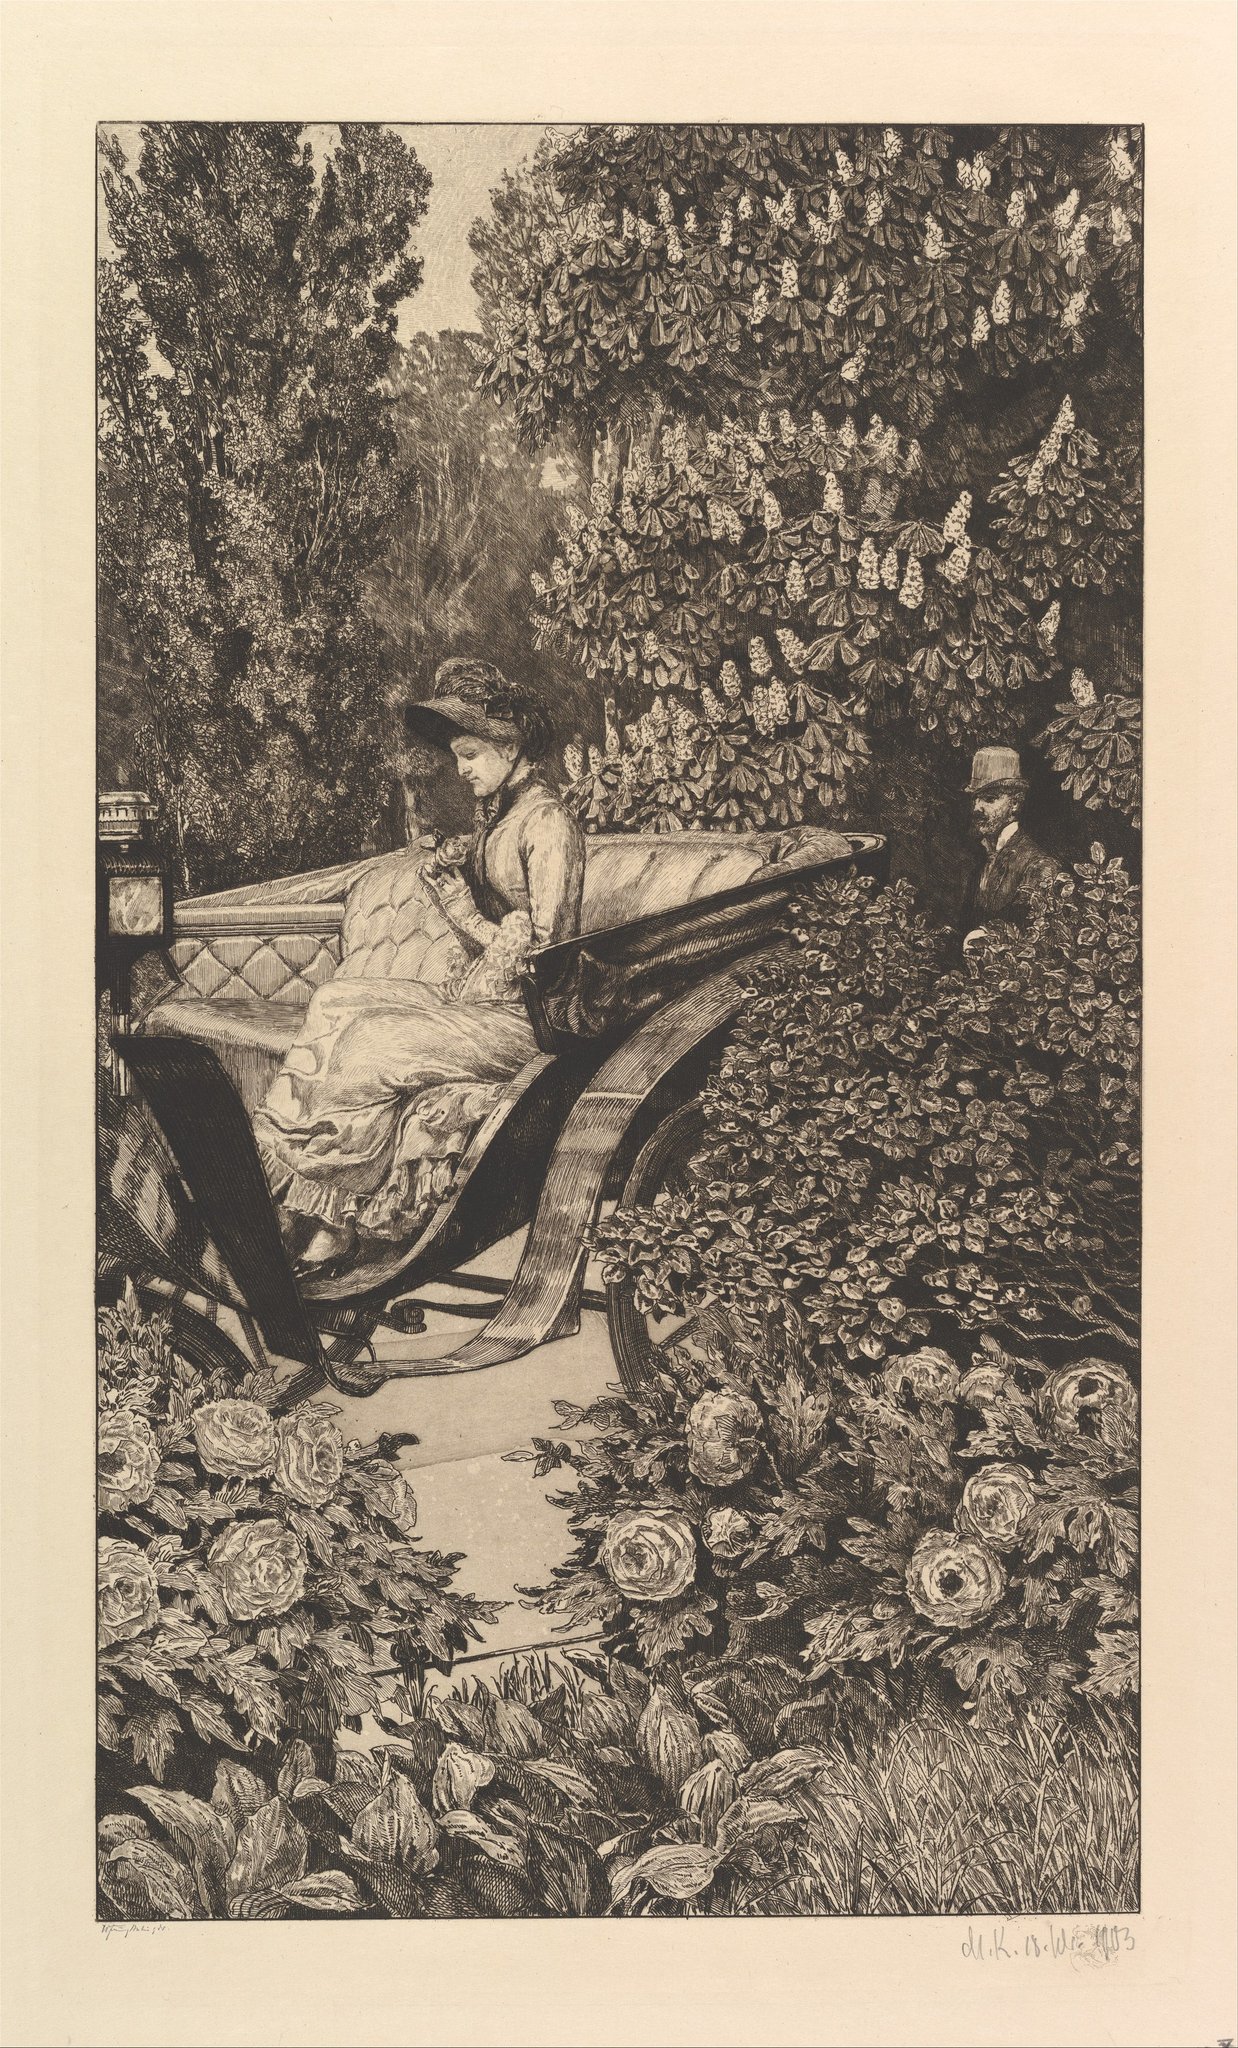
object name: print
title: First Encounter (from the series A Love)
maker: max klinger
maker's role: artist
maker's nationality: german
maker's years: 1857-1920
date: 1887-1903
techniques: aquatint, etching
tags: gardens,men,women,roses